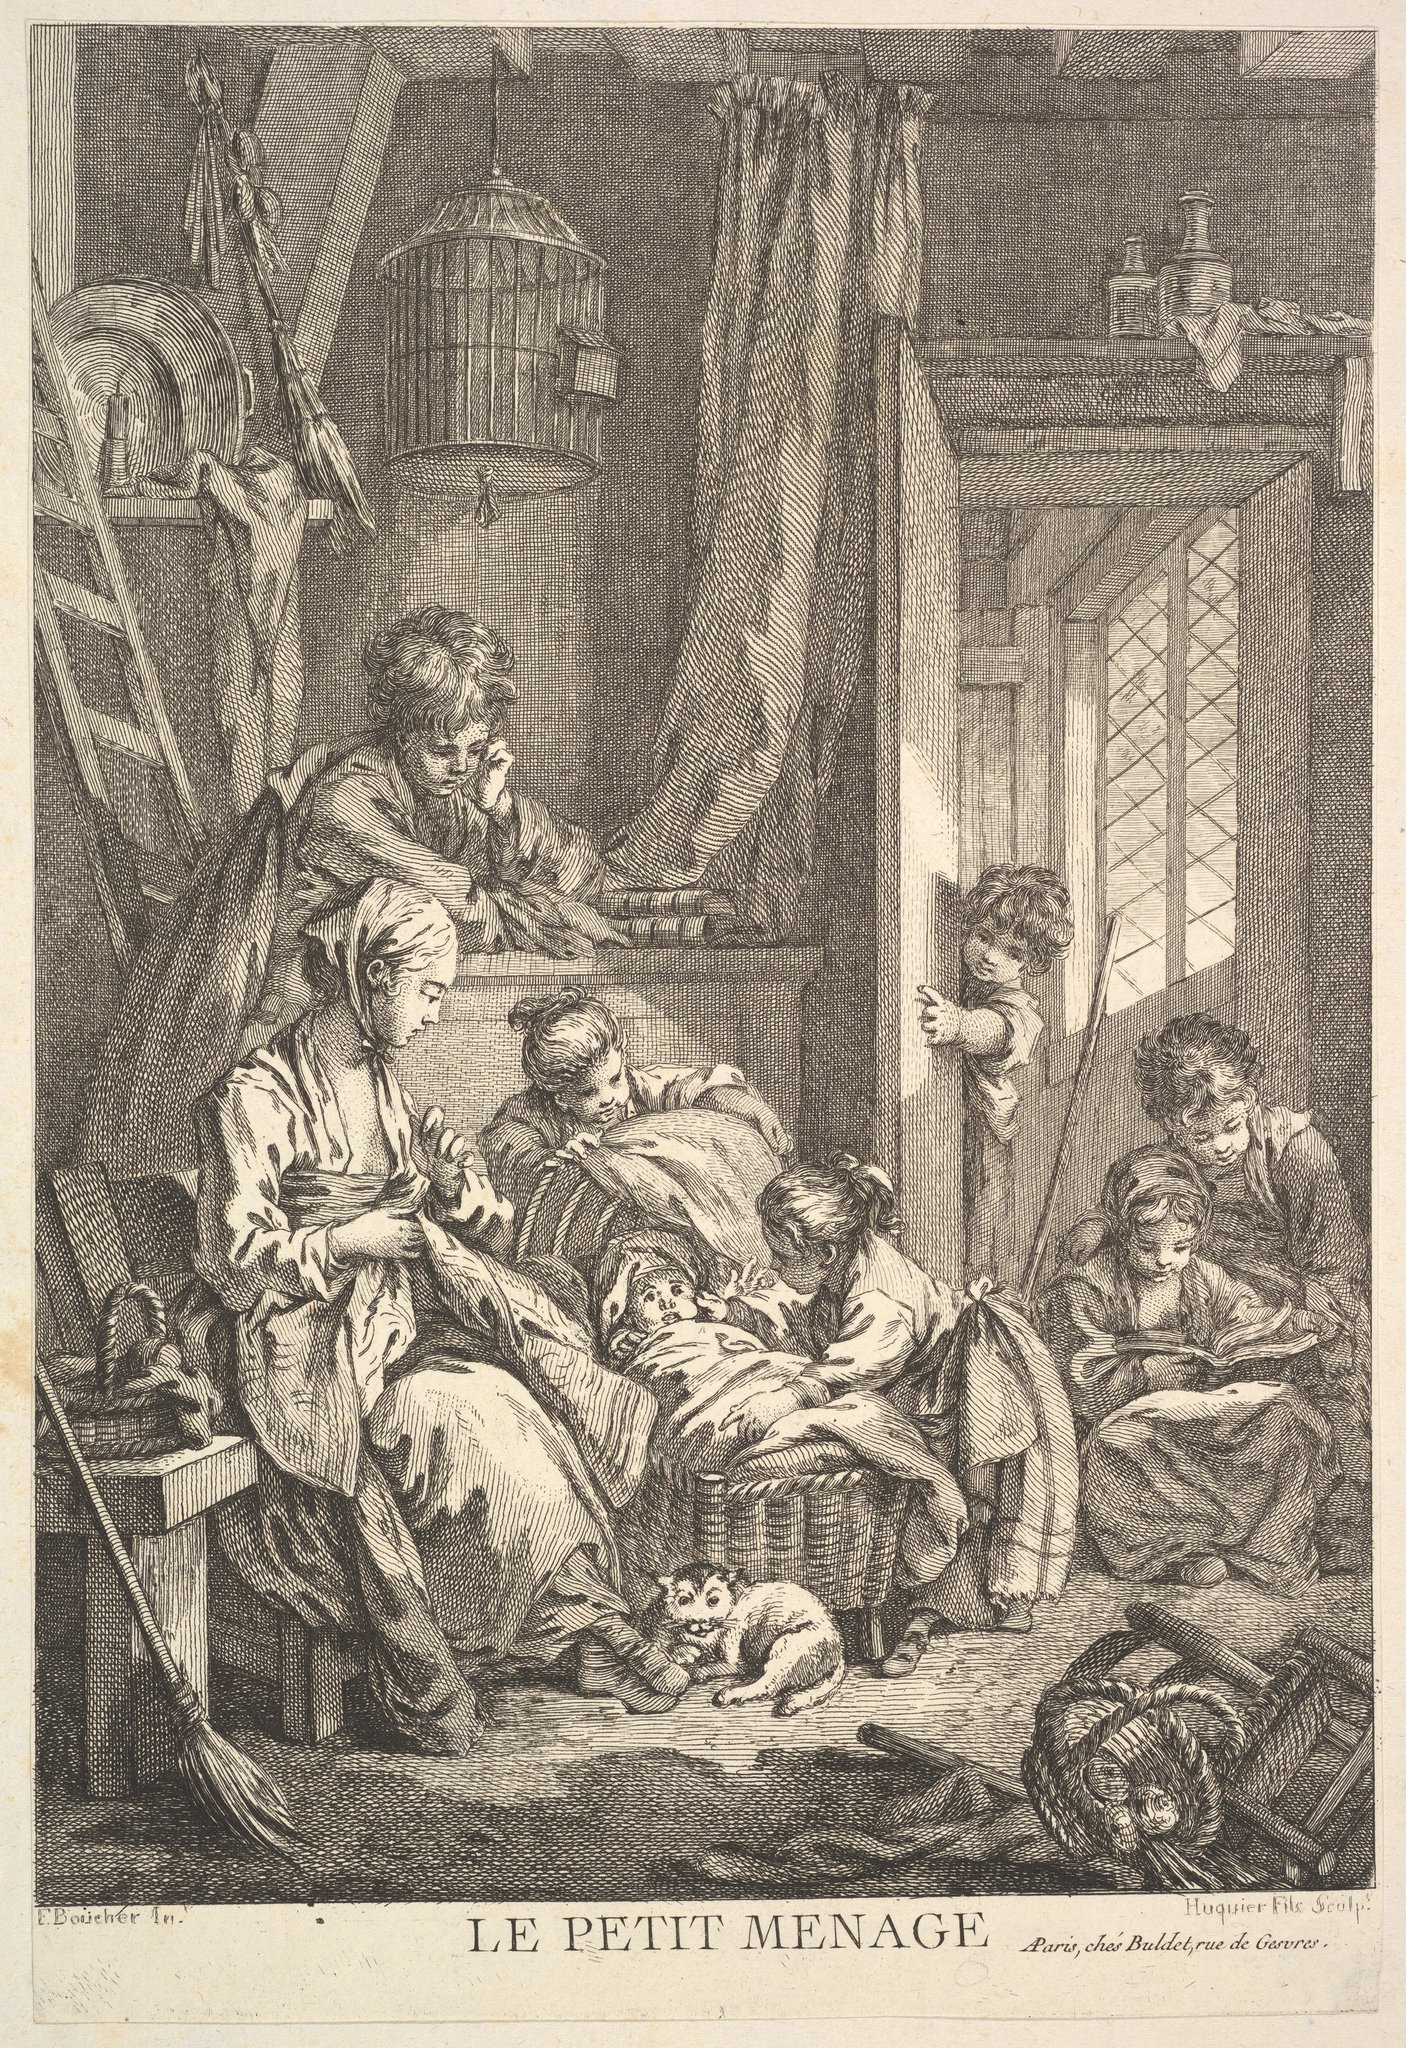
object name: print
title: The Small Household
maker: jacques gabriel huquier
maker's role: artist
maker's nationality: french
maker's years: 1730-1805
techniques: engraving, etching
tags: interiors,children,infants,women,cats,daily life